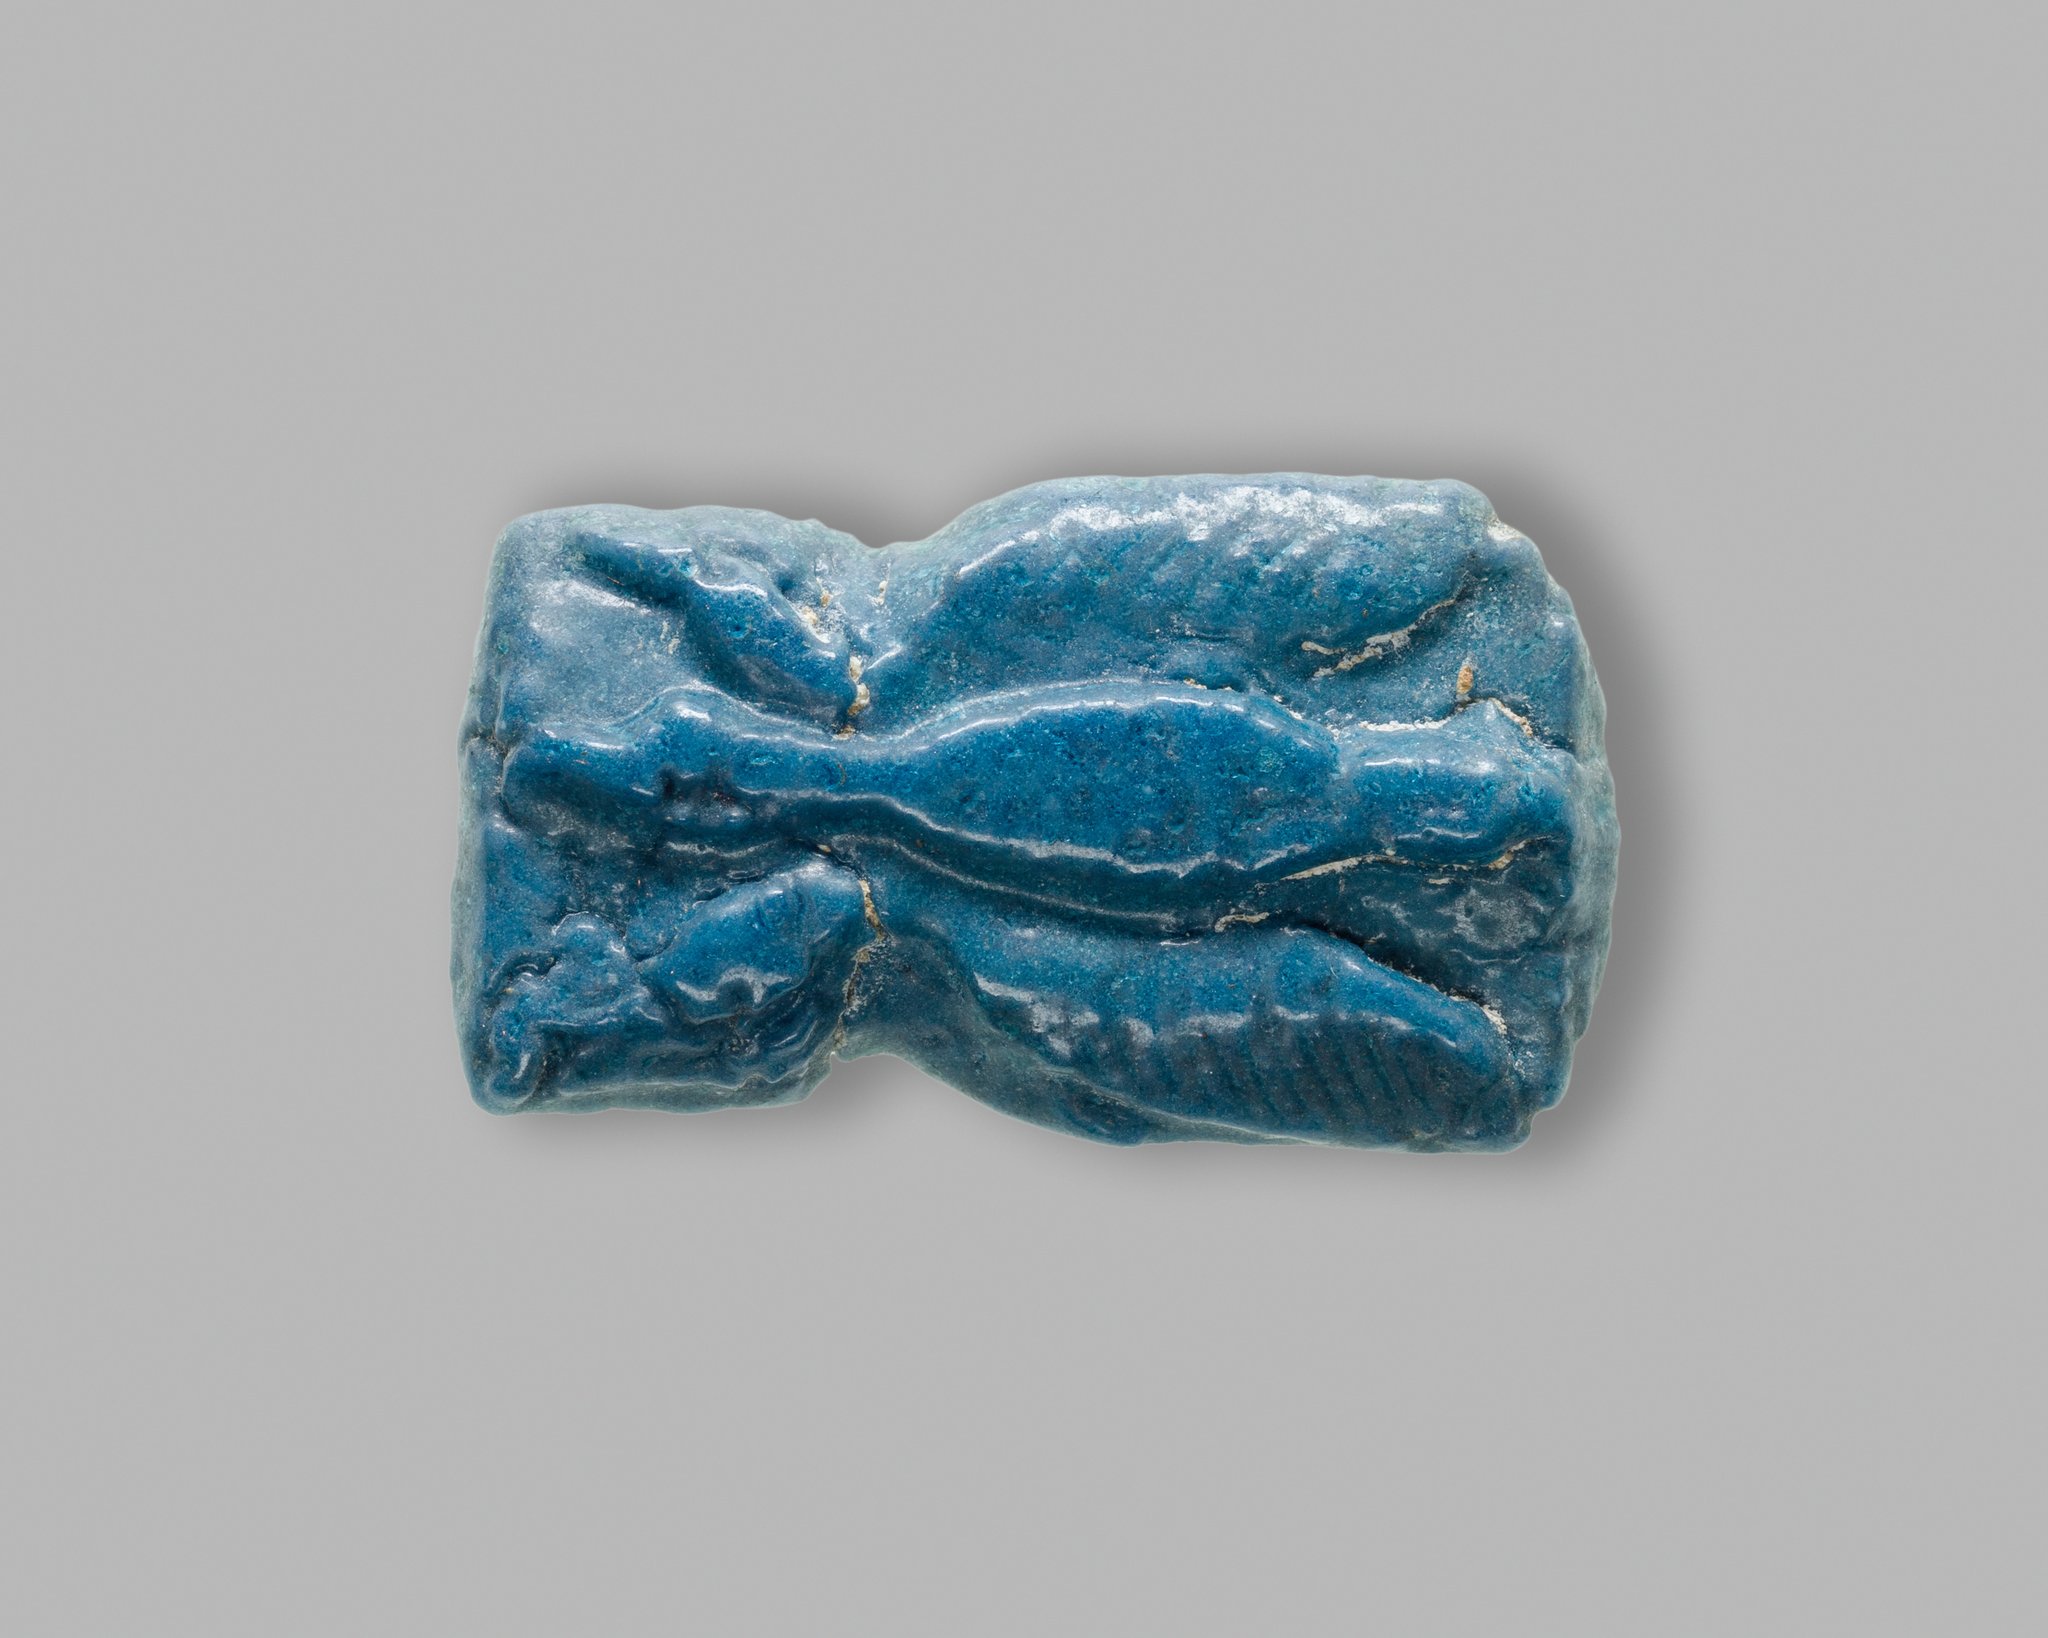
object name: plaque, trussed duck, foundation deposit, tawosret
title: Foundation Deposit Plaque in the Form of a Trussed Duck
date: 1188-1186 BCE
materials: faience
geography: egypt